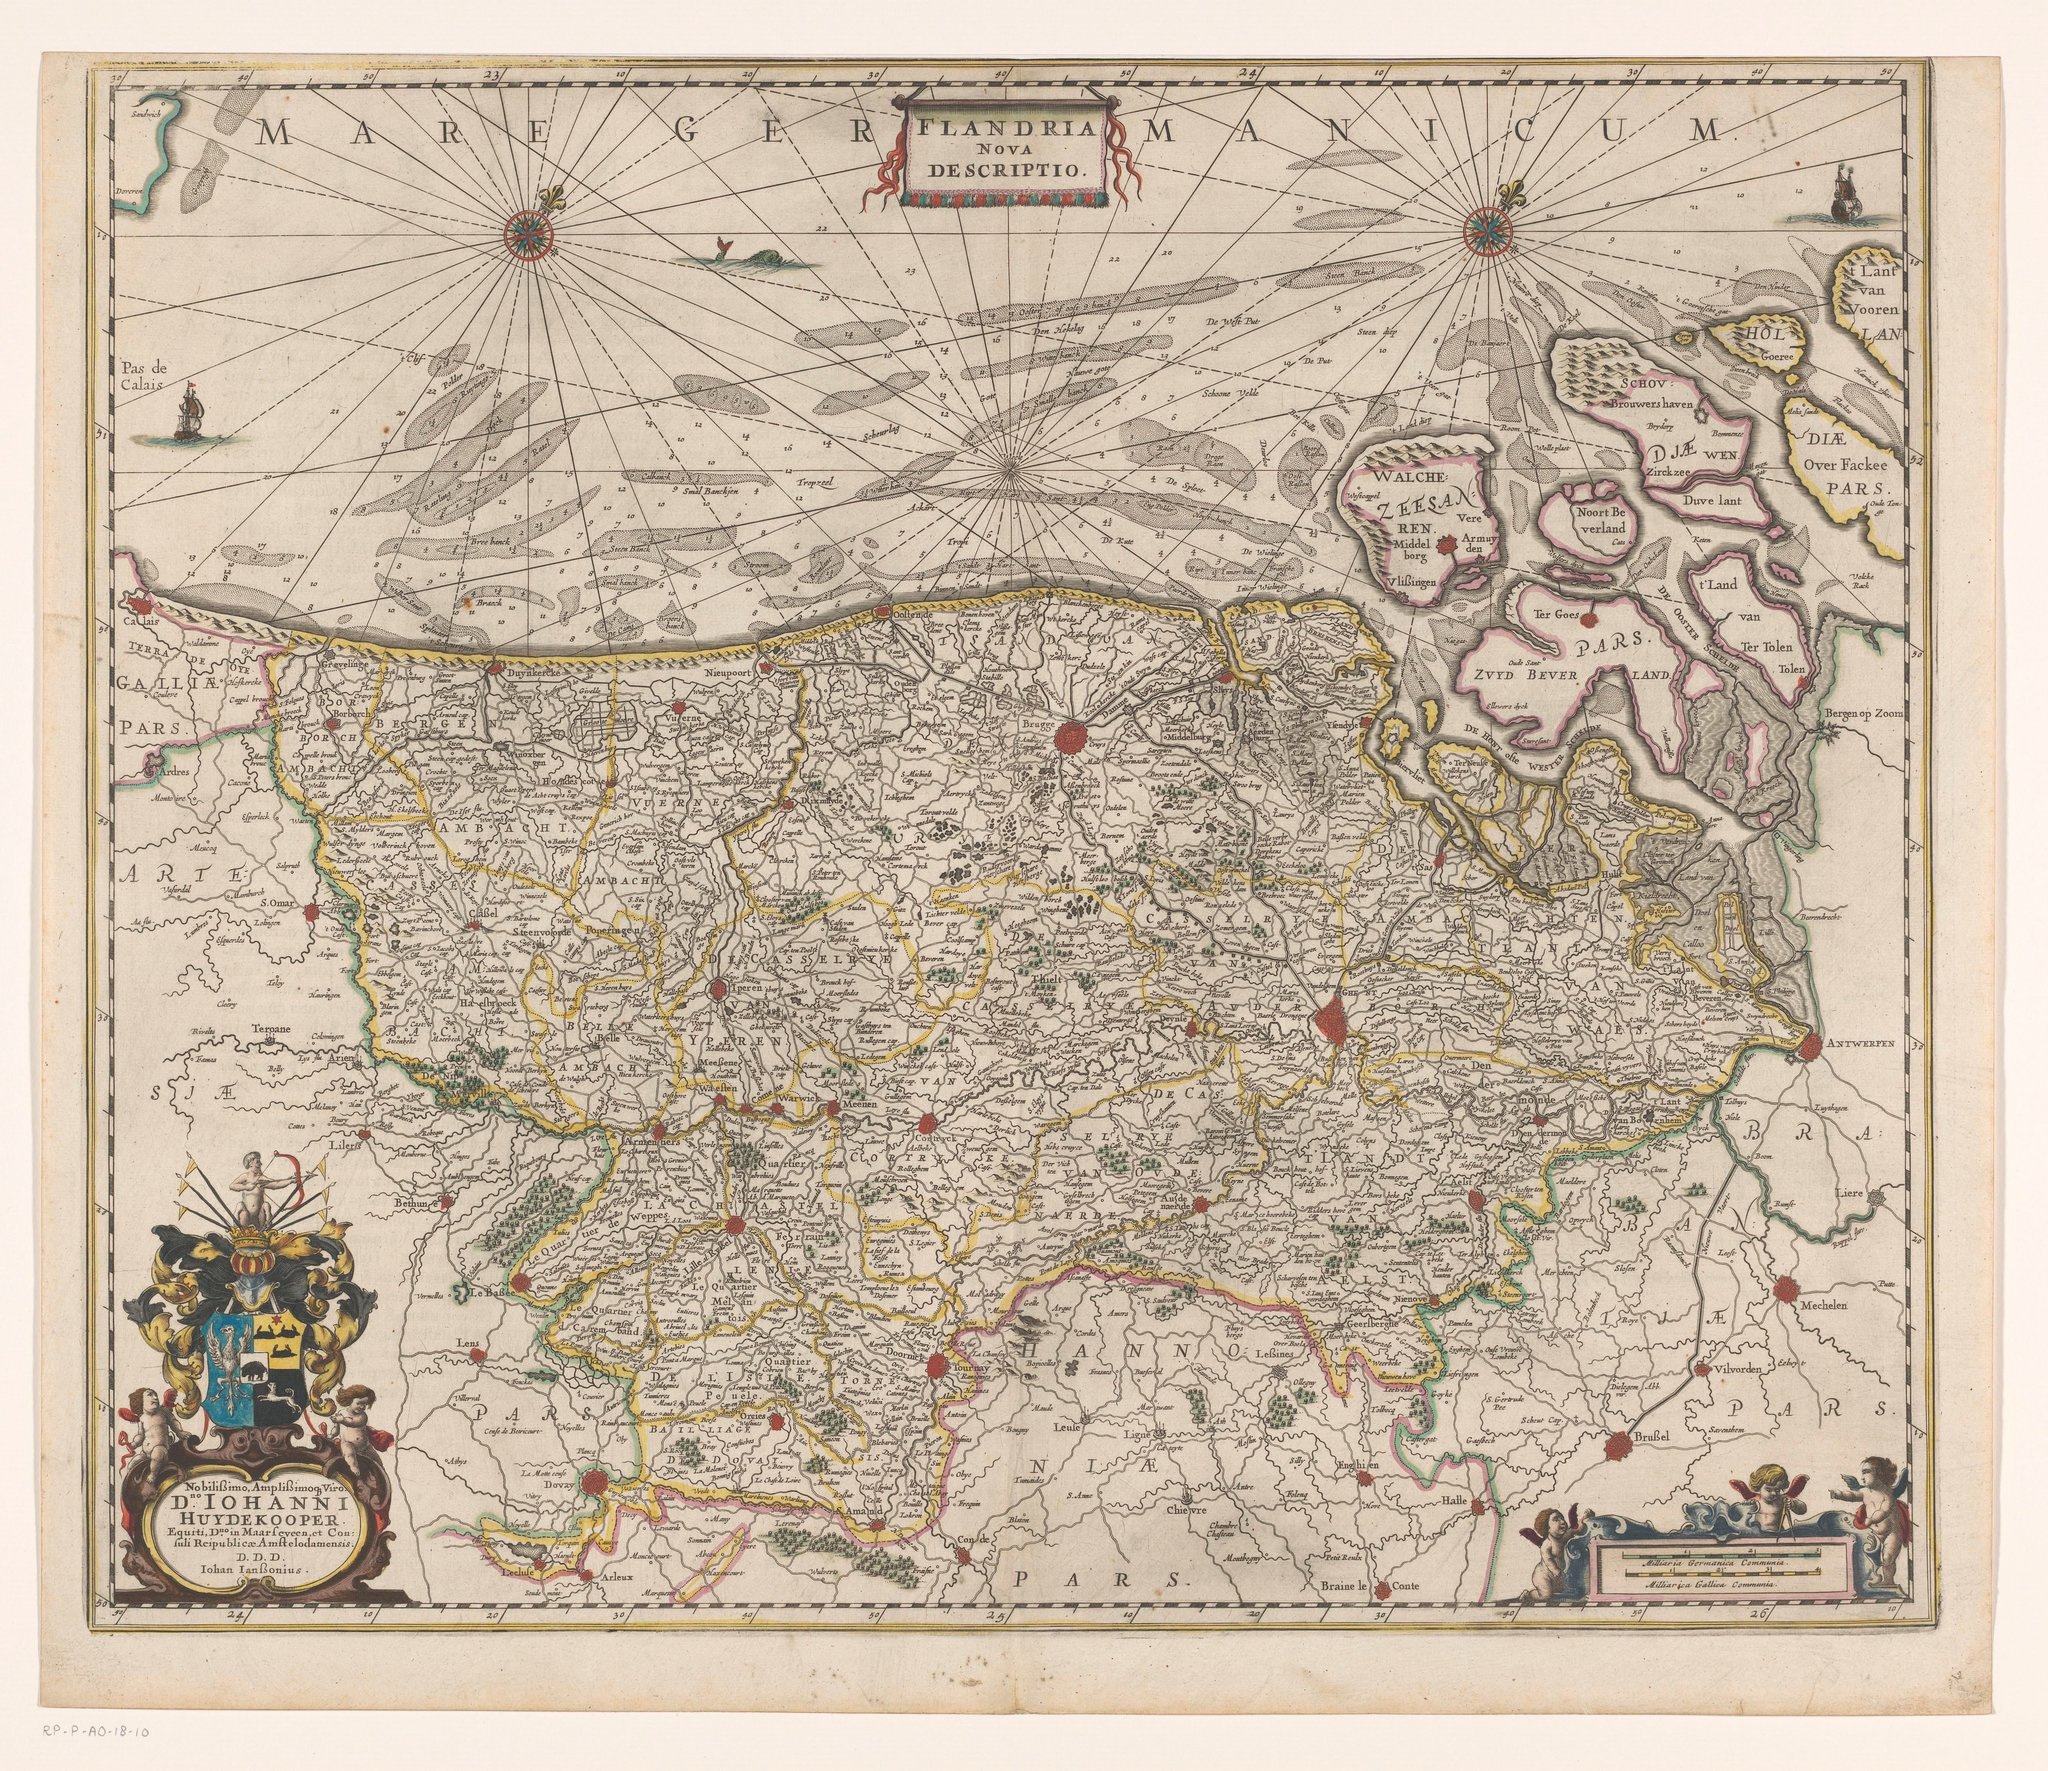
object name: map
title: Kaart van Vlaanderen en Zeeland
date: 1666-1680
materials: paper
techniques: engraving, etching, hand coloring, letterpress printing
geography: amsterdam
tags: maps of separate countries or regions, armorial bearing, heraldry, zeeland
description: Prent gebruikt in: Janssonius, Johannes. Atlas Contractus, sive Atlantis Majoris Compendium (…). 2 delen. Amsterdam: erven Johannes Janssonius, 1666, dl. 1. Of in: Janssonius, Johannes. Atlas Major, sive Cosmographia Universalis (…). Amsterdam: erven Johannes Janssonius, 1675, dl. 3. Of in: Novus Atlas, sive Theatrum Orbis Terrarum: Tabulae & Descriptiones Omnium Regionum Totius Universi Accuratissime Exhibentur. 5 delen. Amsterdam: Johannes Janssonius van Waesberge (I), s.d. [na ca. 1680], dl. 2.